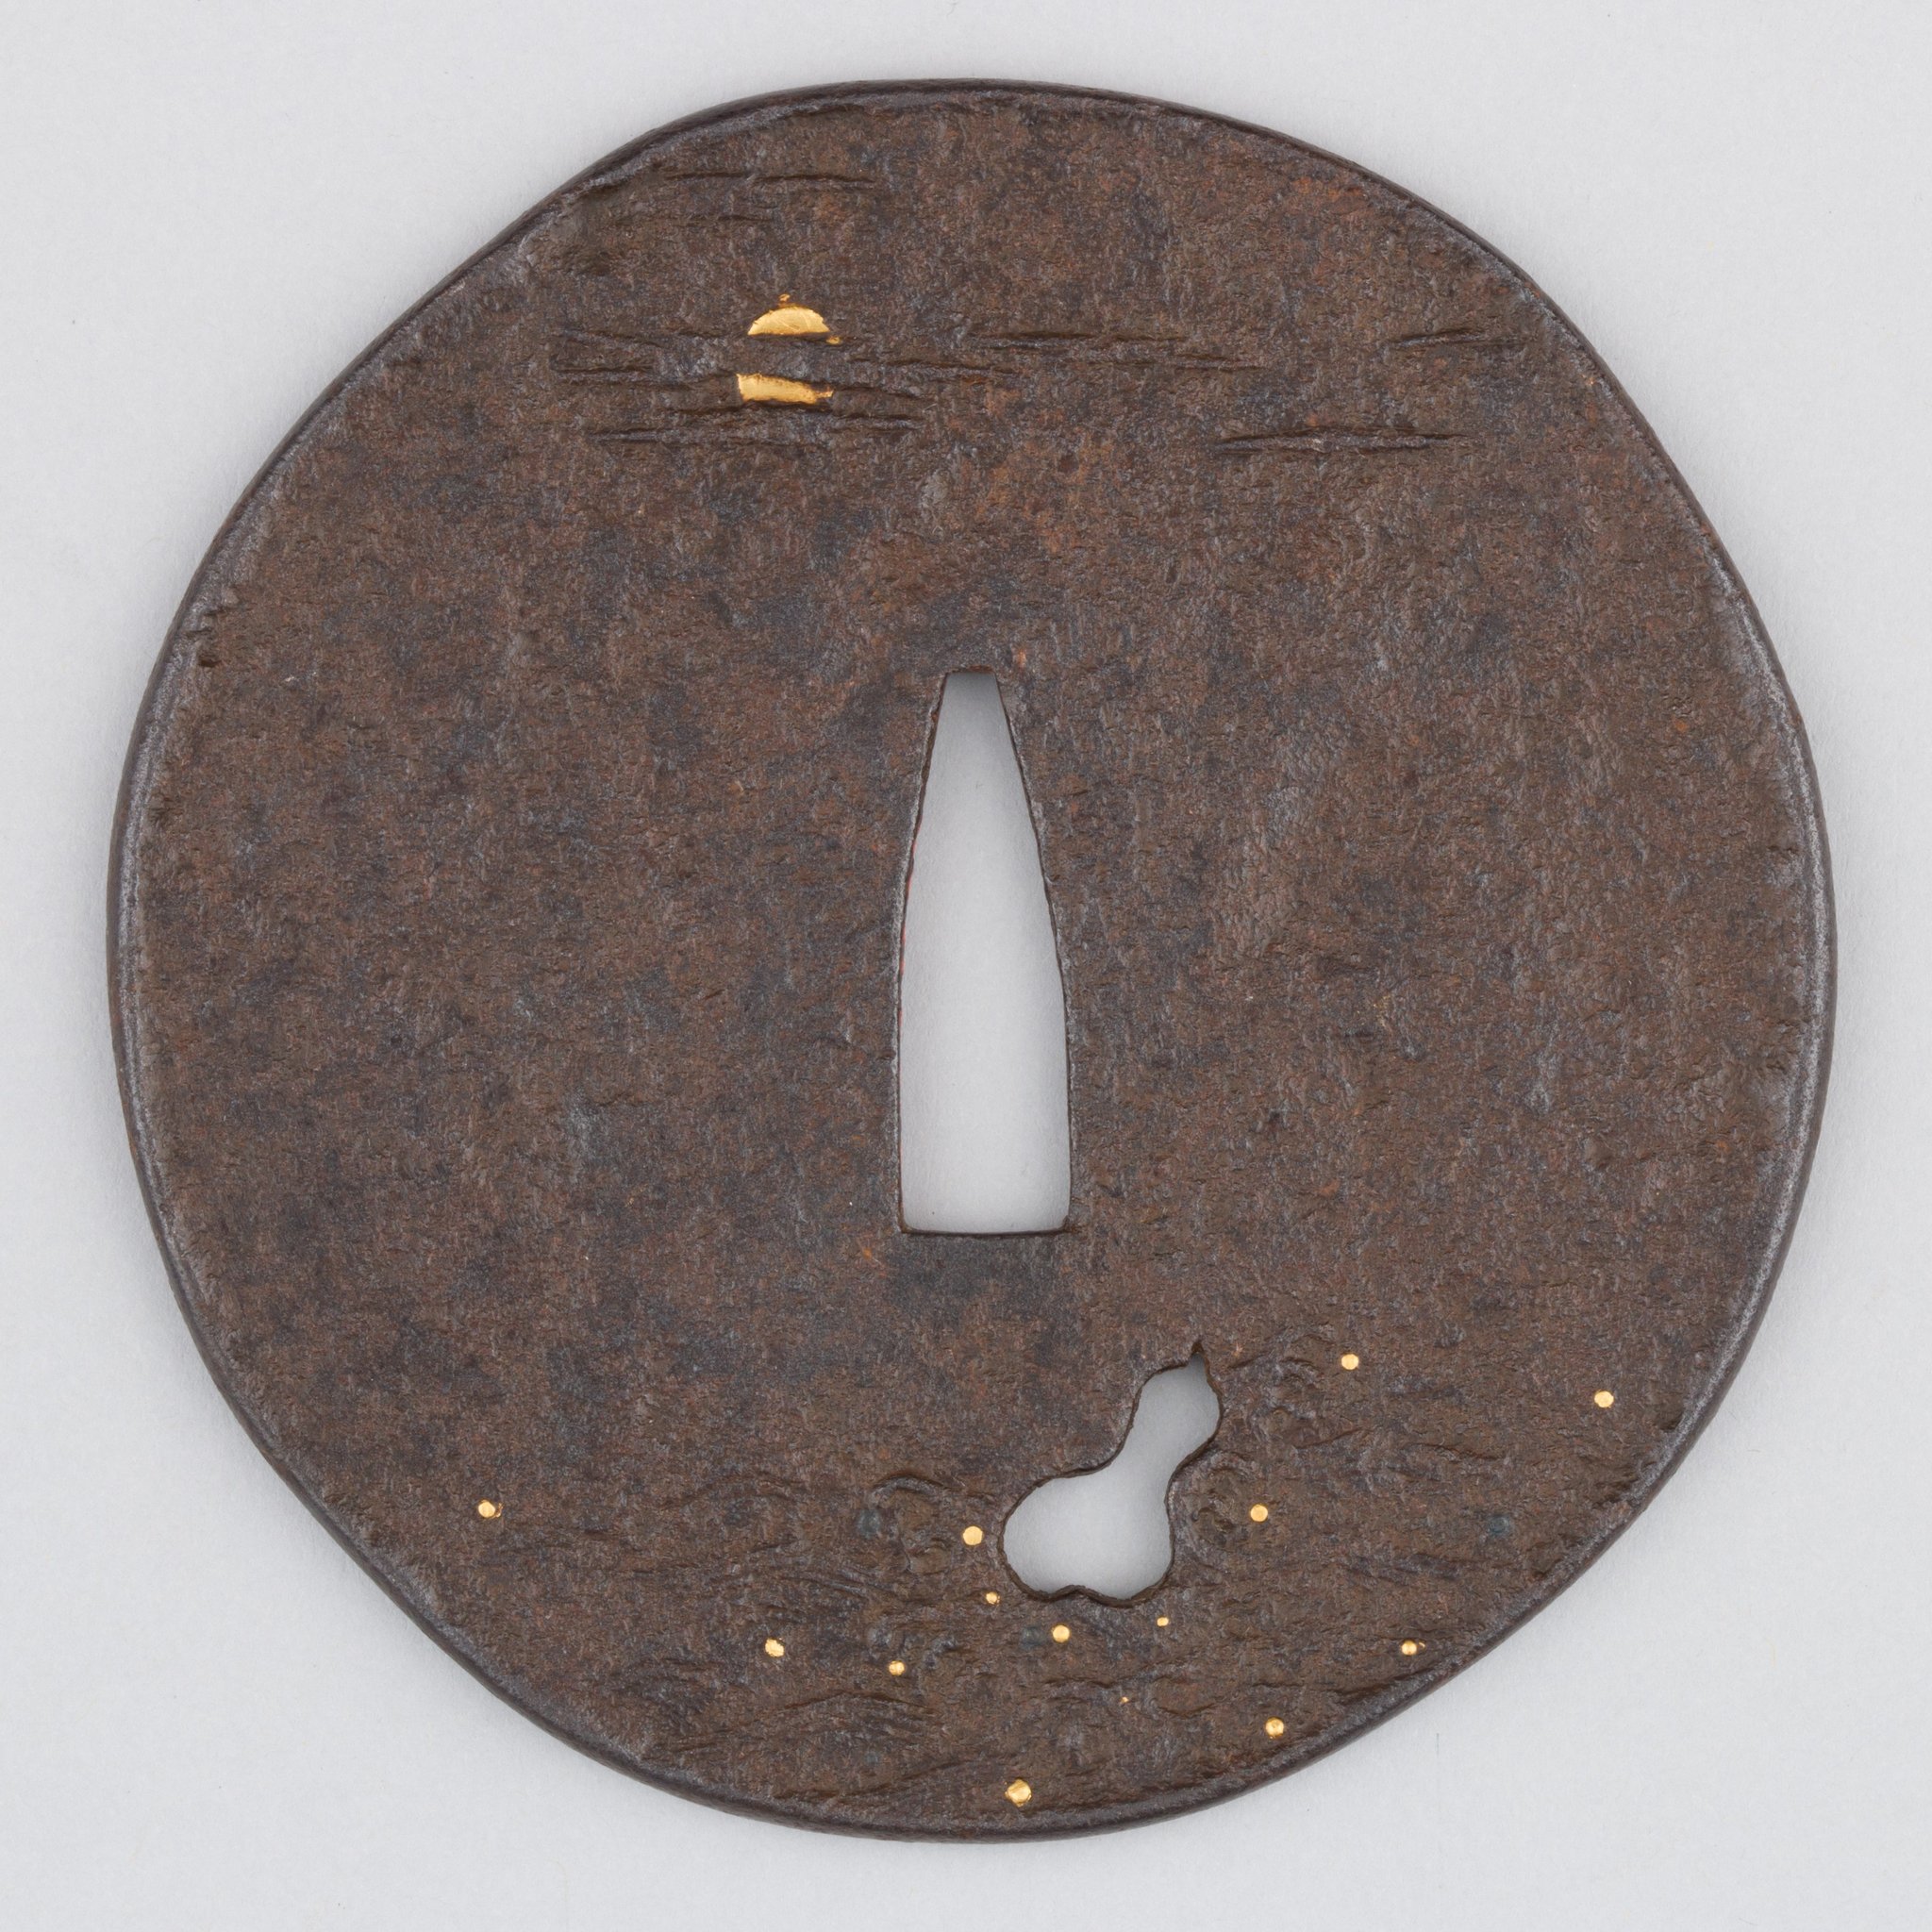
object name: sword guard tsuba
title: Sword Guard (Tsuba)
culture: japanese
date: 1601-1700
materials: copper, gold, iron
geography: japan